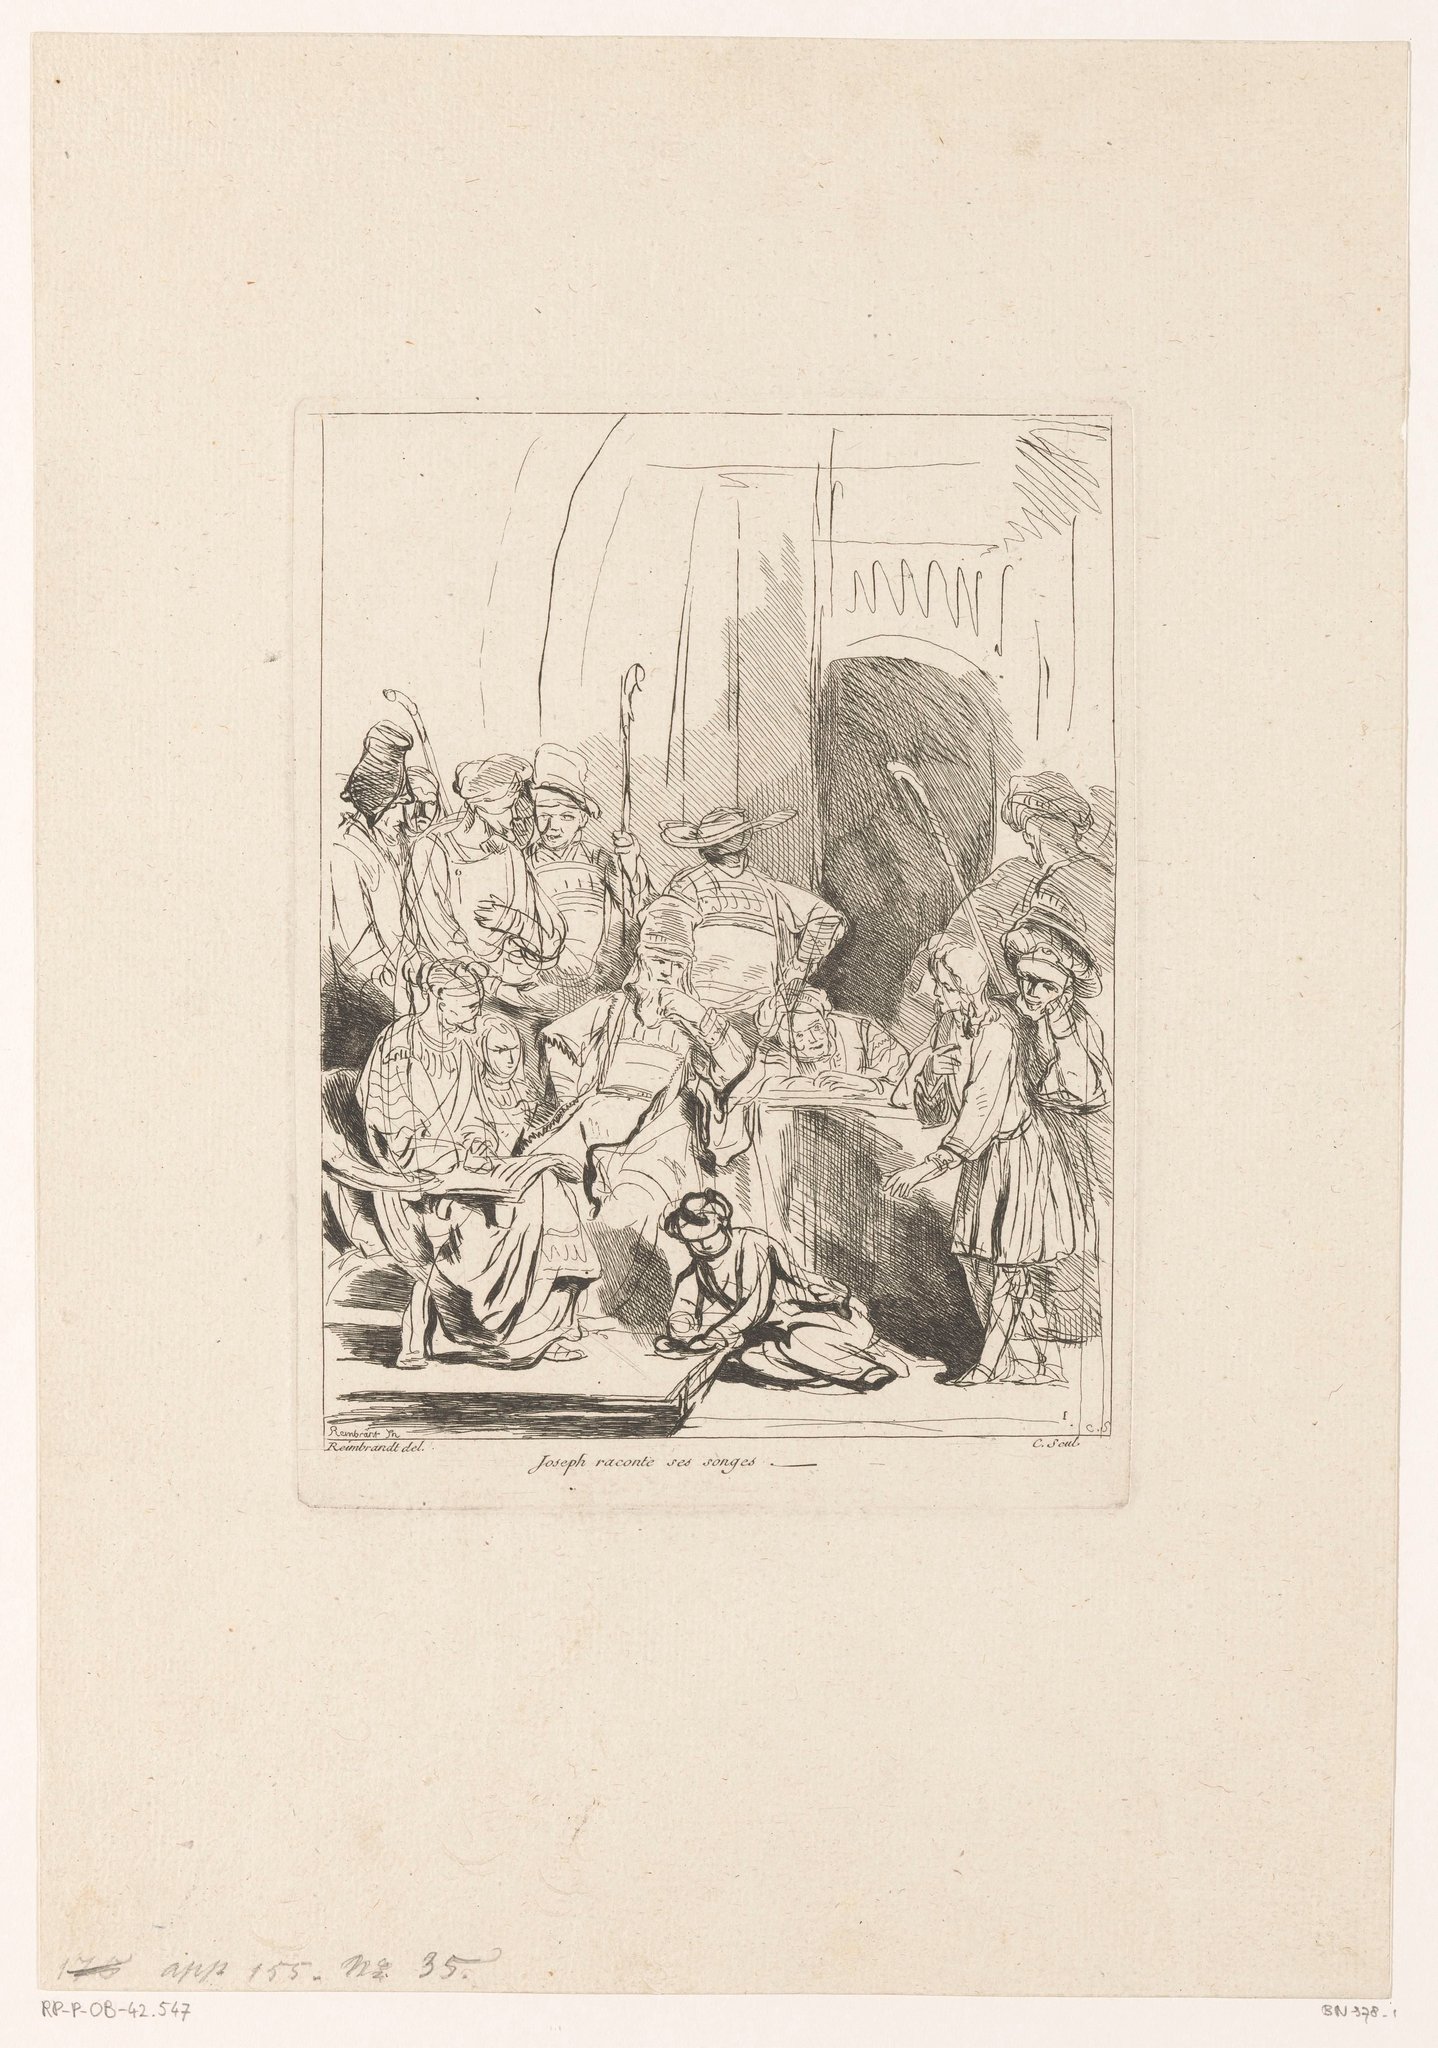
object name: print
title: Joseph raconte ses songes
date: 1702-1753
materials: paper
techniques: etching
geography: france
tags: joseph's dreams, genesis: the story of joseph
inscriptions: collector's mark: Lugt 240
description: Maakt deel uit van een serie getiteld: "Histoire de Joseph", bestaande uit tien platen naar tekeningen, voorheen toegeschreven aan Rembrandt, maar tegenwoordig gecatalogiseerd als tekeningen in de manier van Rembrandt, waarbij de naam Gerbrandt van den Eeckhout wordt gesuggereerd. De serie wordt genoemd in een veilingcatalogus van Coypel in 1753. In 1757 werd de serie uitgegeven door Jean Néaulme in Amsterdam.